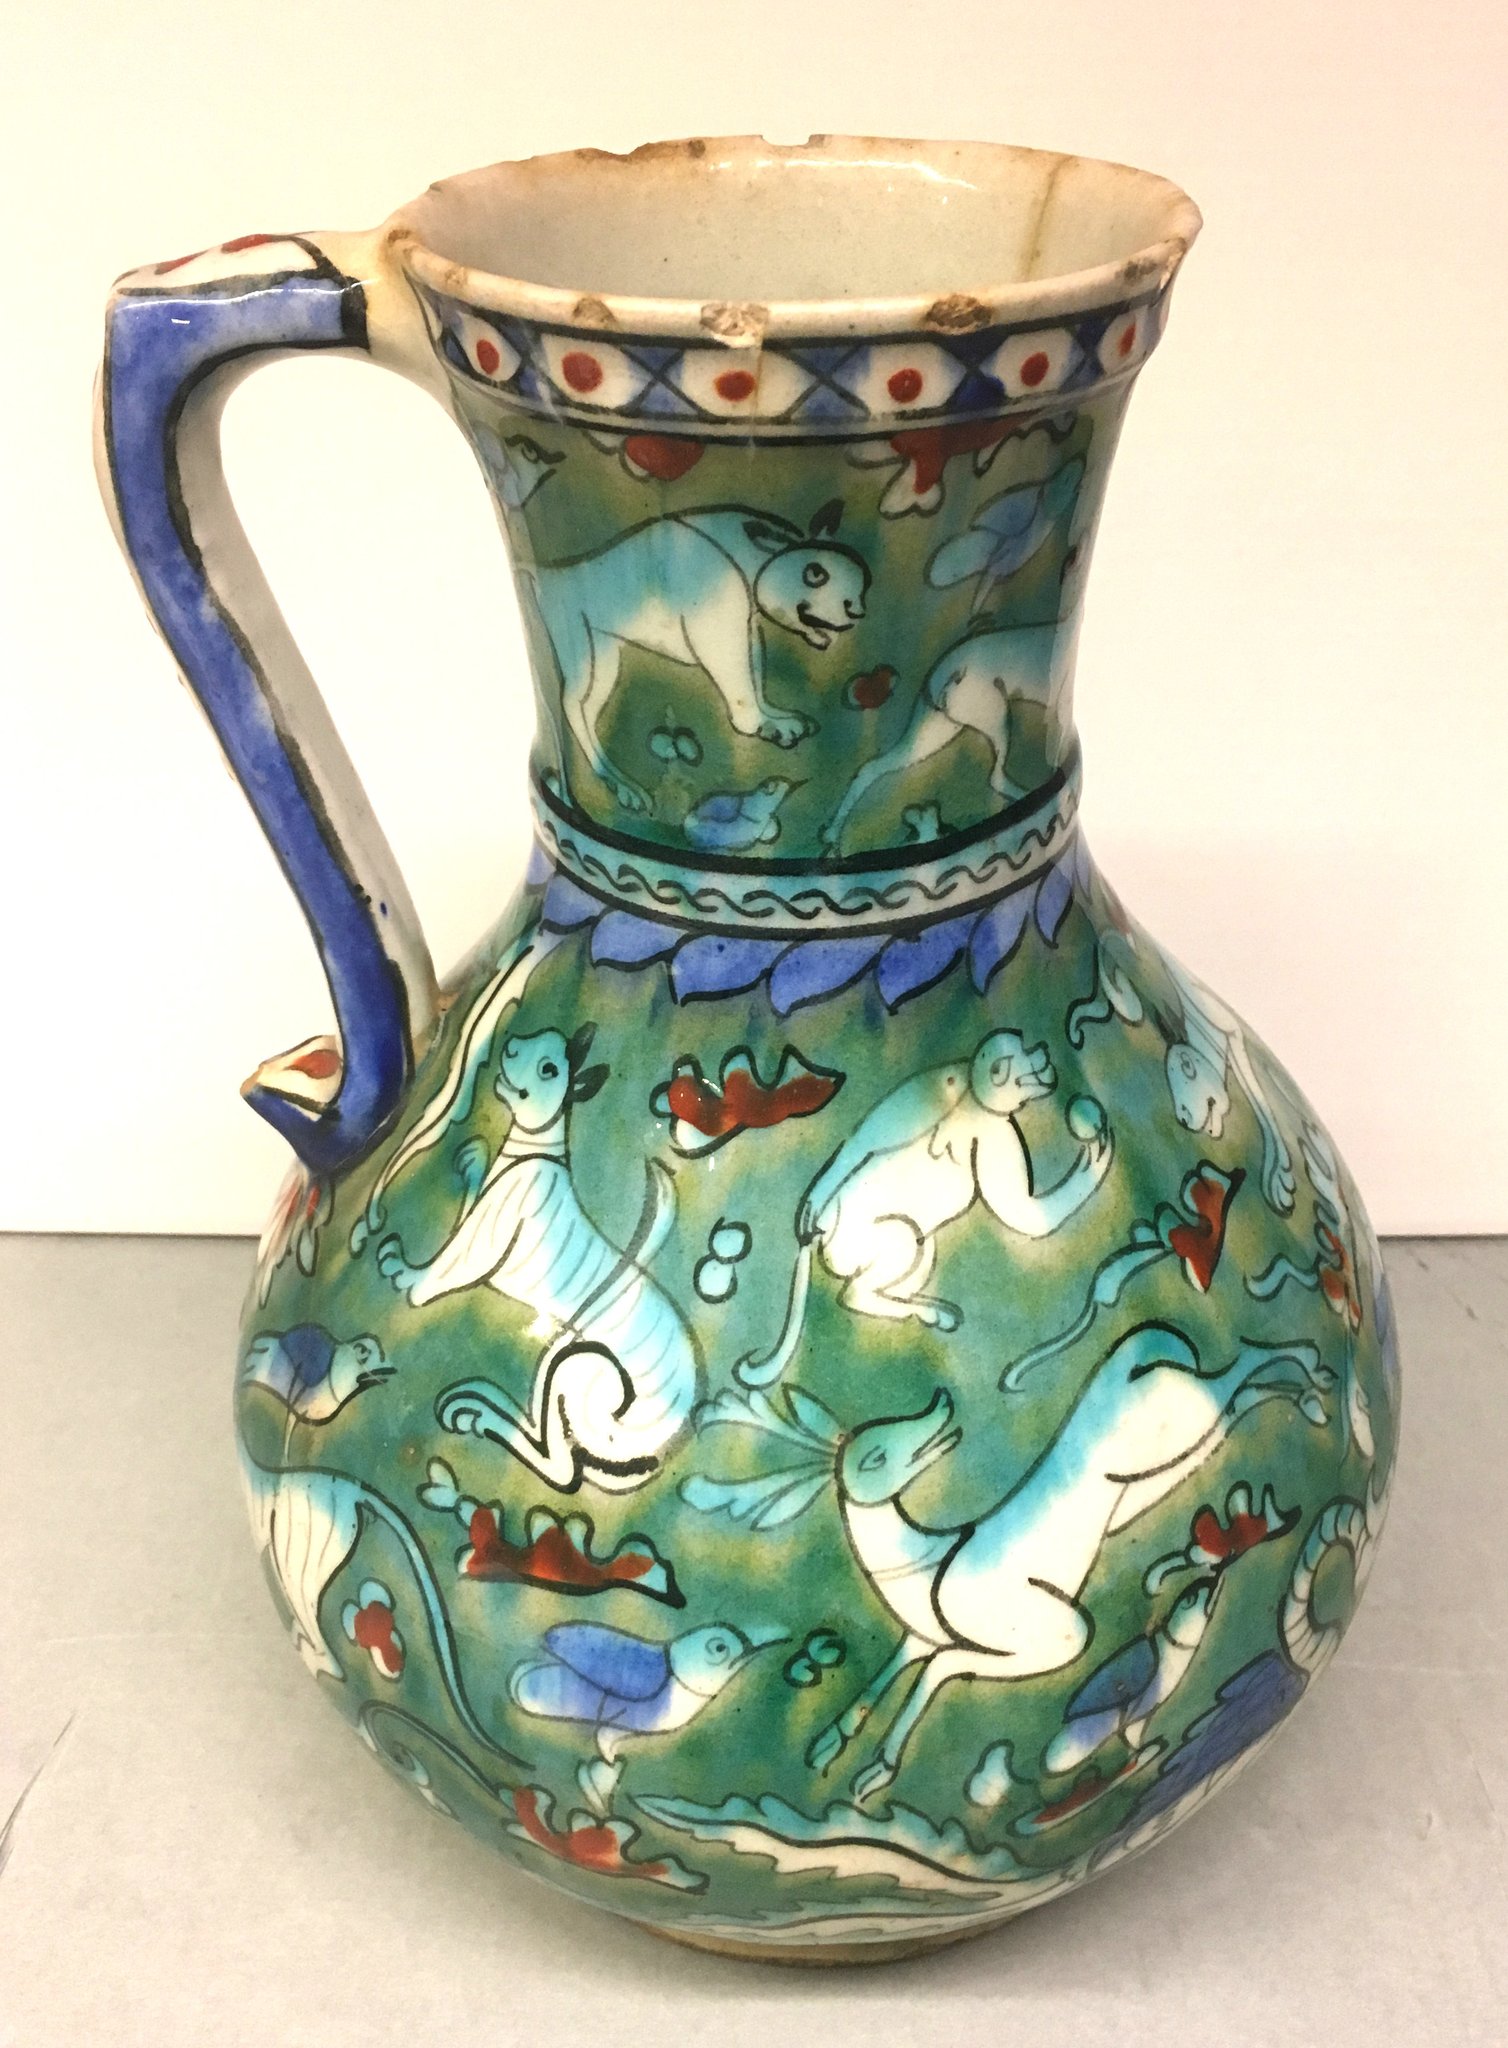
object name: ewer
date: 1576-1600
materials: stonepaste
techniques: glazing, painting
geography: turkey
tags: birds,deer,lions